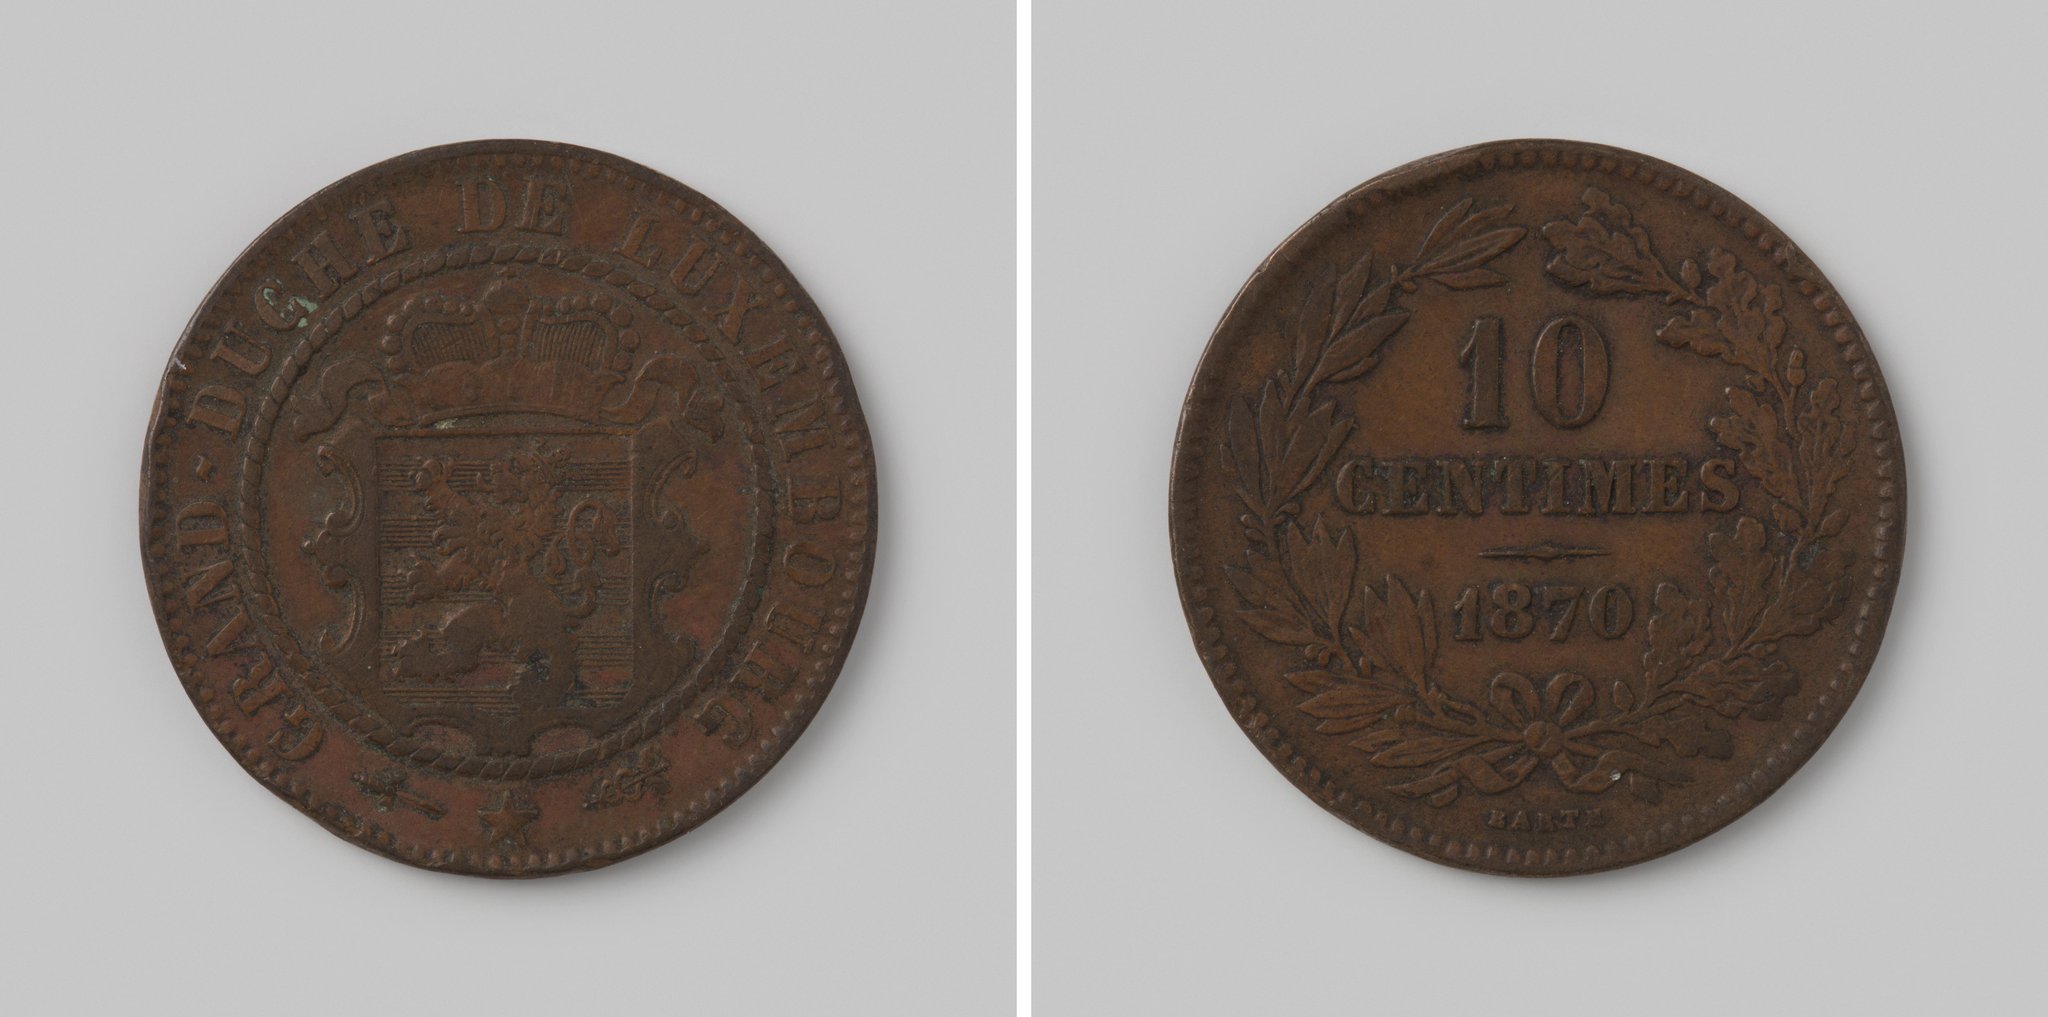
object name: tien centime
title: Luxemburgse 10 centimes van Willem III, 1870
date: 1870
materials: copper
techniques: striking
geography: brussels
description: Koperen munt. Voorzijde: gekroond versierd wapenschild met onderaan muntmeester- en muntteken [van Utrecht!]. Keerzijde: tussen een samengebonden laurier- en eikentak in twee regels waarde-aanduiding, waaronder jaartal. Gladde rand.